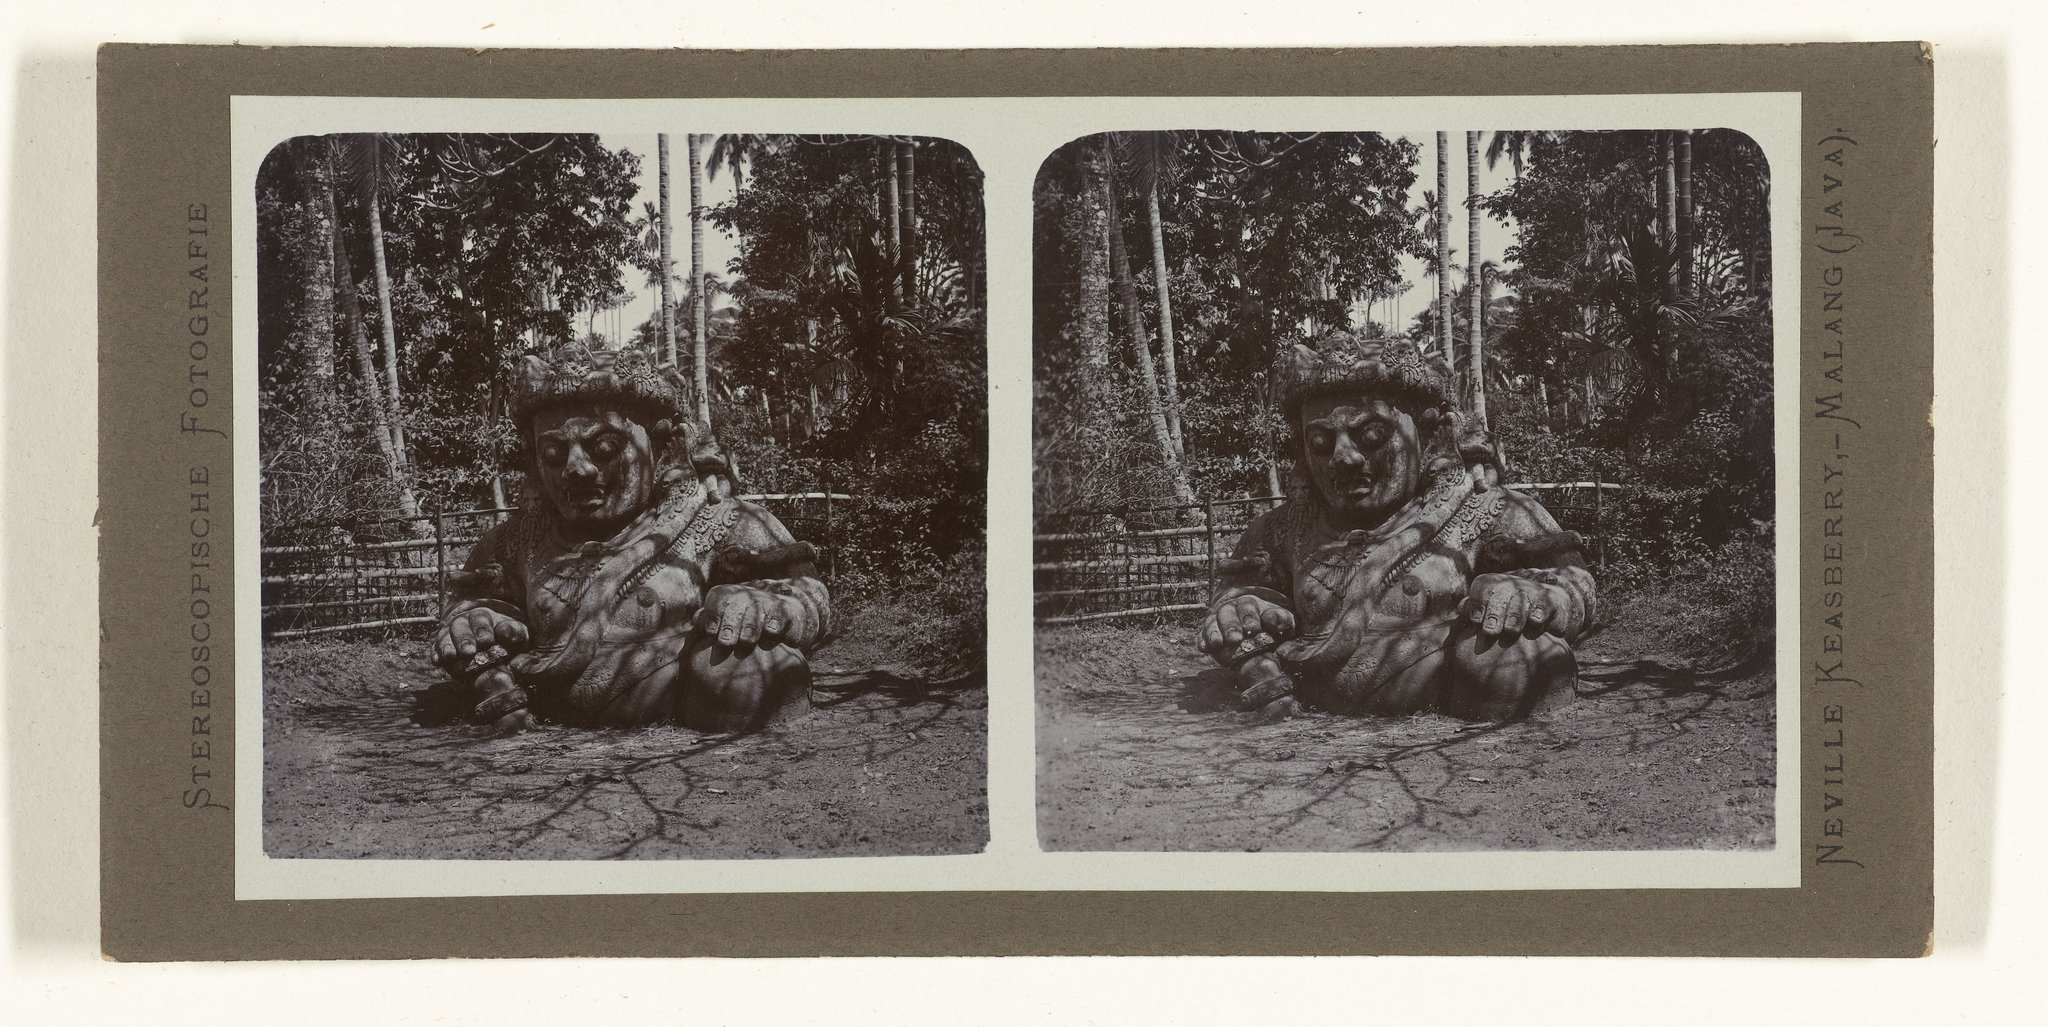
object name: photograph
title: S 2 No 24. De Reuzentempel wachter te Singosari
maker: neville keasberry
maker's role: fotograaf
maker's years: 1866-1944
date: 1900-1935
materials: cardboard, paper, photographic support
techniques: albumen print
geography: malang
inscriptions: signature: ‘Neville Keasberry, Malang (Java)’, inscription: ‘Stereoscopische Fotografie’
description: Een grote tempelwachter met bolle ogen en een kroon van menselijke schedels.